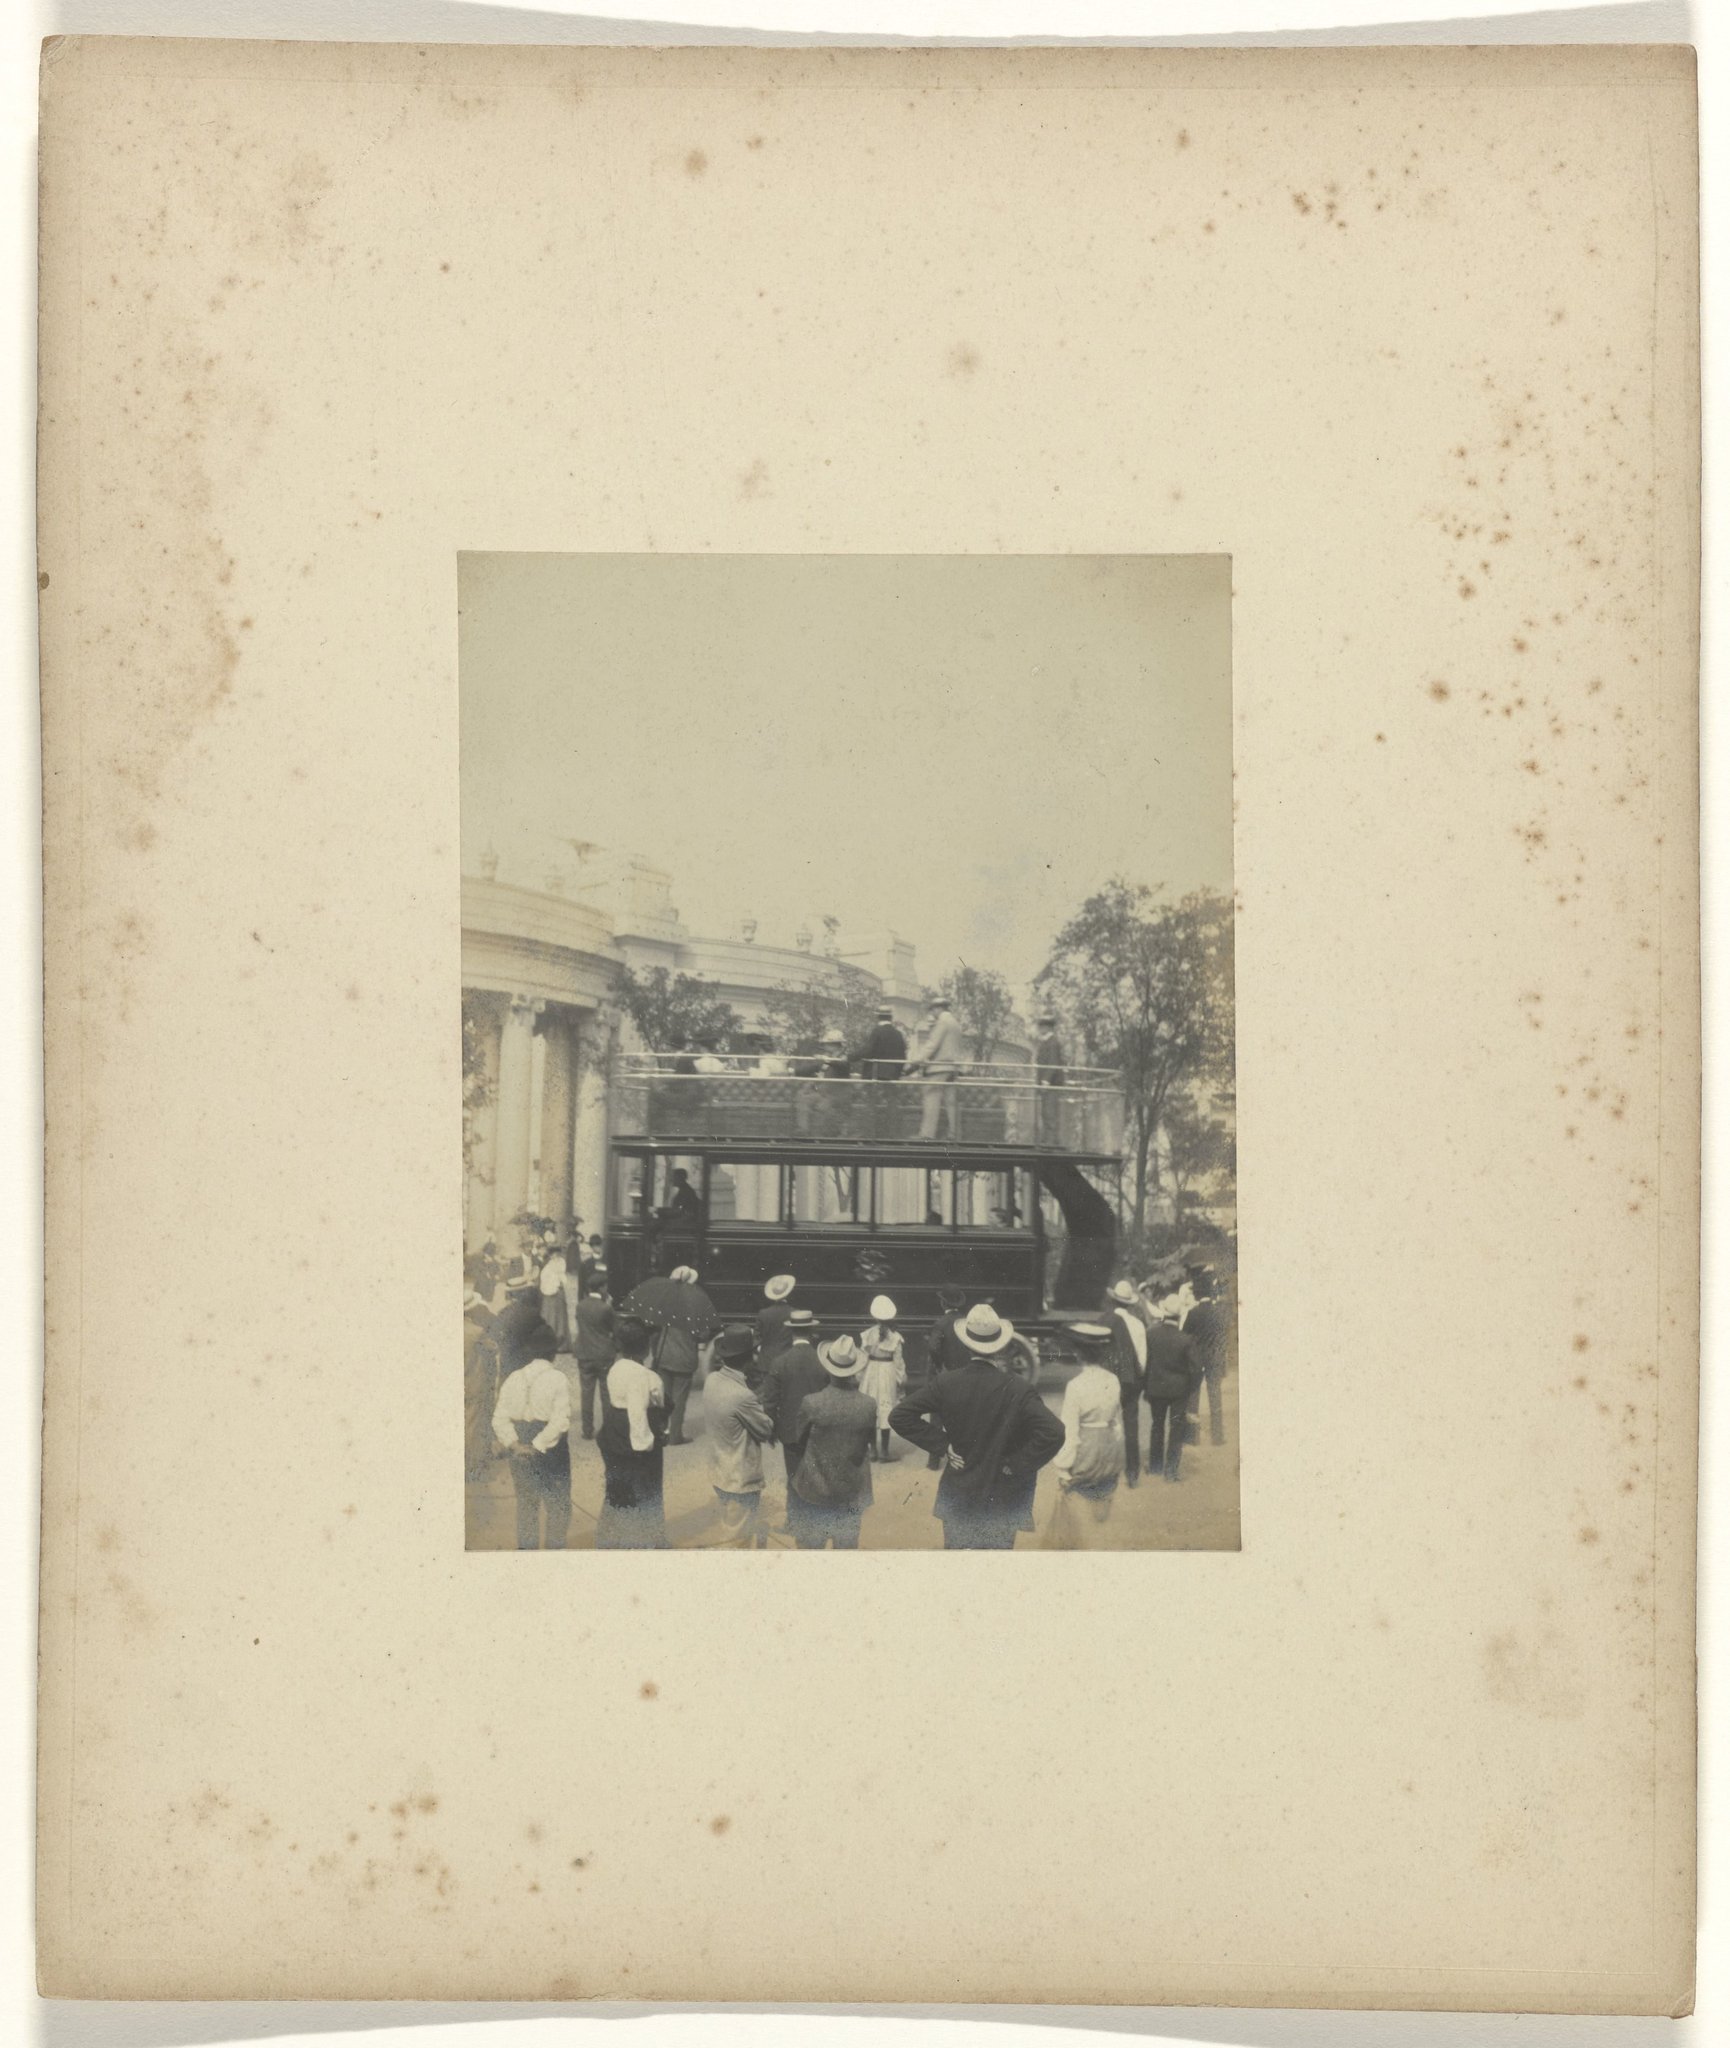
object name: photograph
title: Parade van auto’s (autobussen) op de wereldtentoonstelling in St. Louis (Louisiana Purchase Exposition), 1904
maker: jan schüller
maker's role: draughtsman, painter, print maker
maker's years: 1871-1915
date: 1904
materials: cardboard, paper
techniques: gelatin silver print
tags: bus, coach, world fair, world exhibition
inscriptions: annotation: ‘Automobile parade // De groote Auto van Busch’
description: Parade van auto’s (autobussen) op de wereldtentoonstelling in St. Louis (Louisiana Purchase Exposition), 1904.